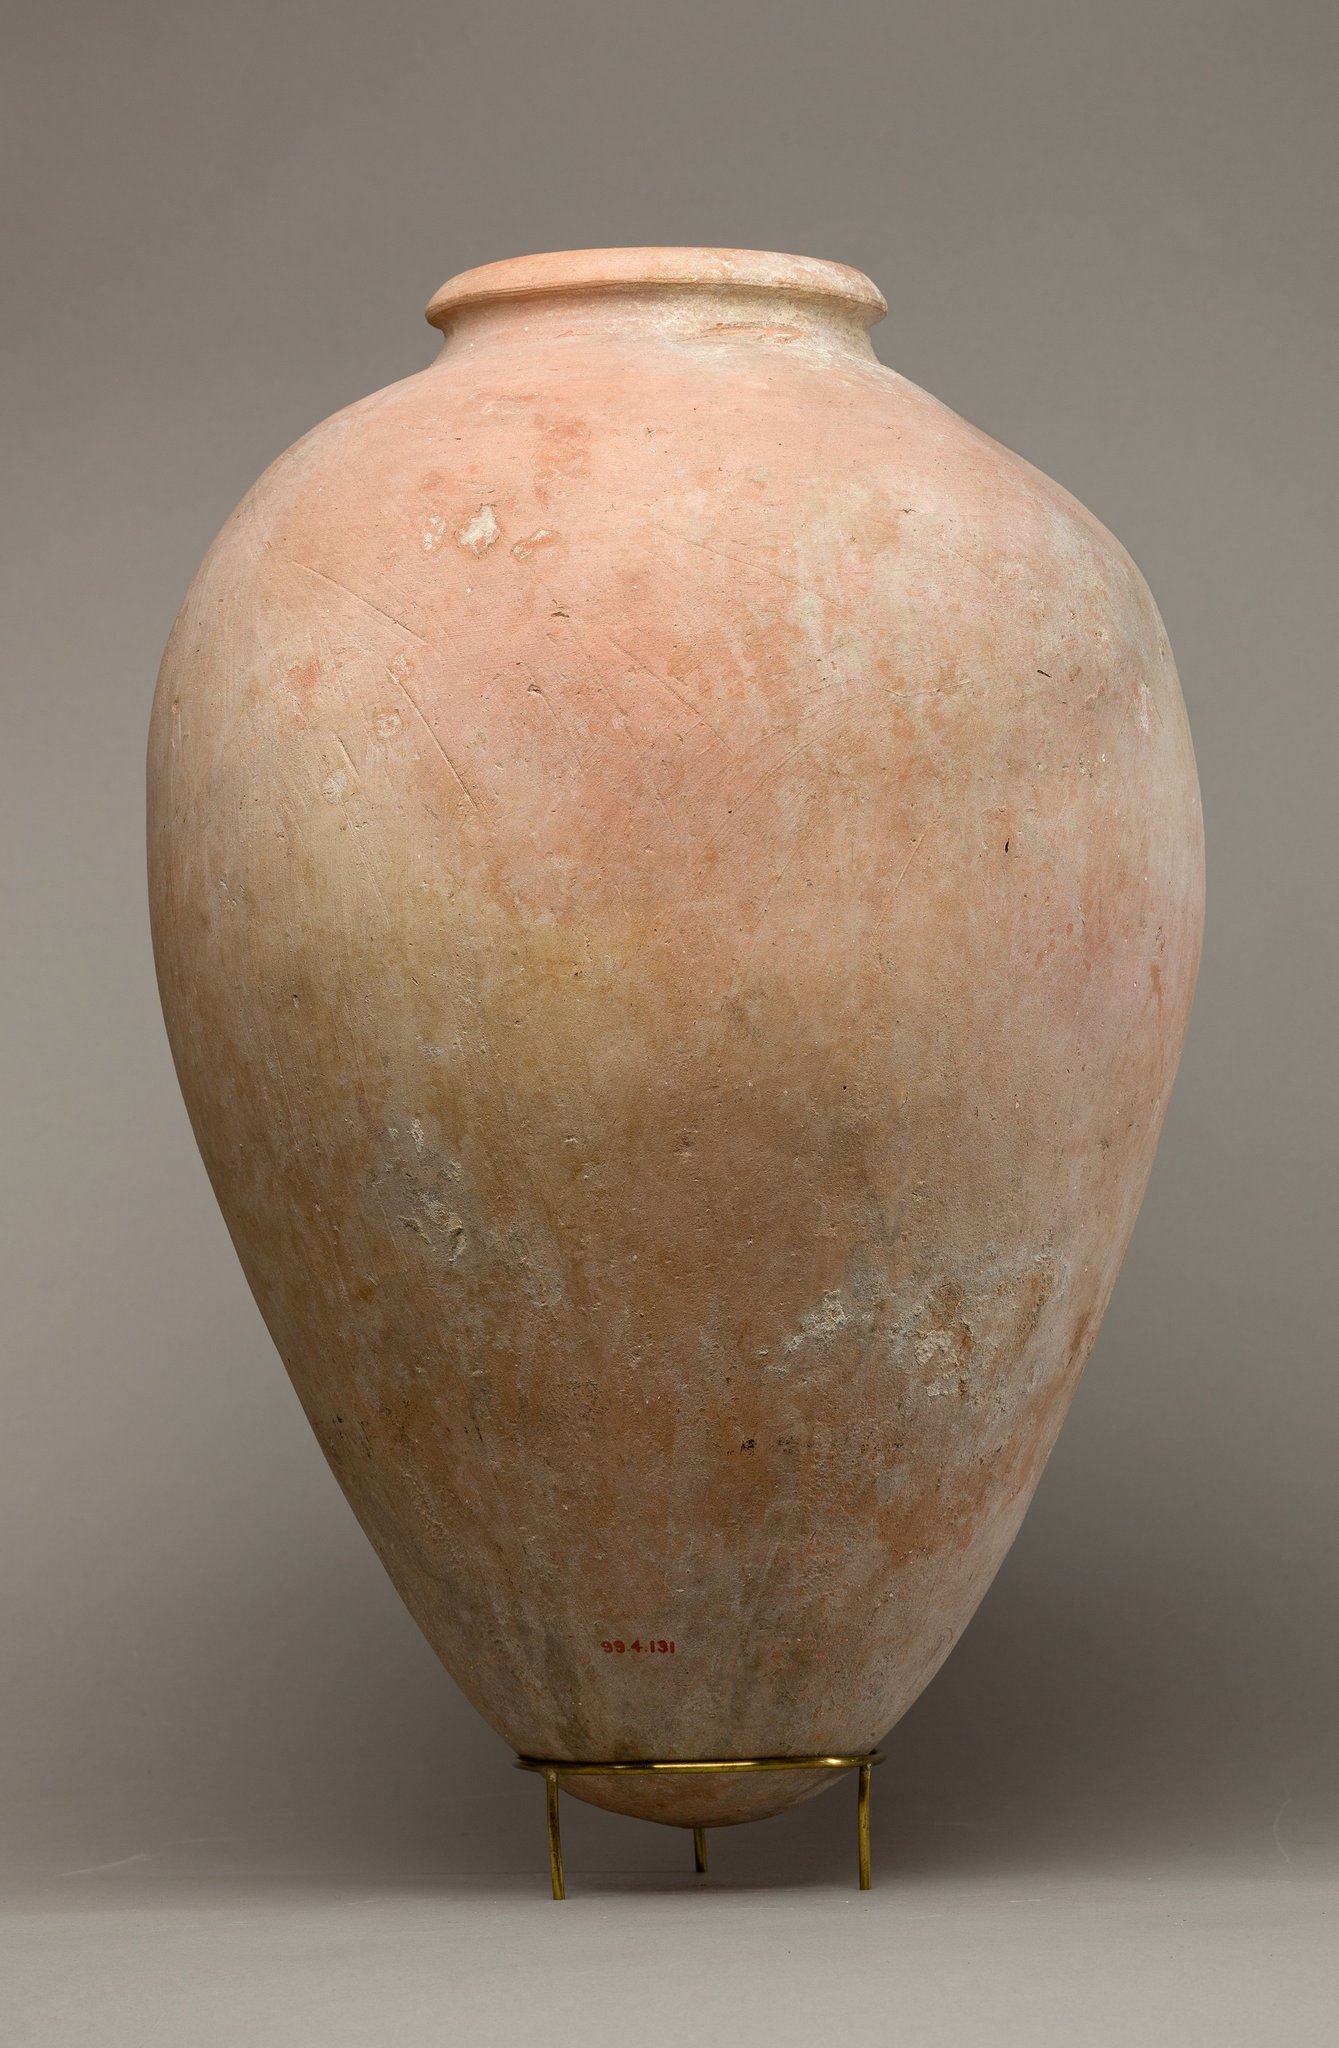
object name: jar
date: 3850-2960 BCE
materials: pottery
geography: egypt